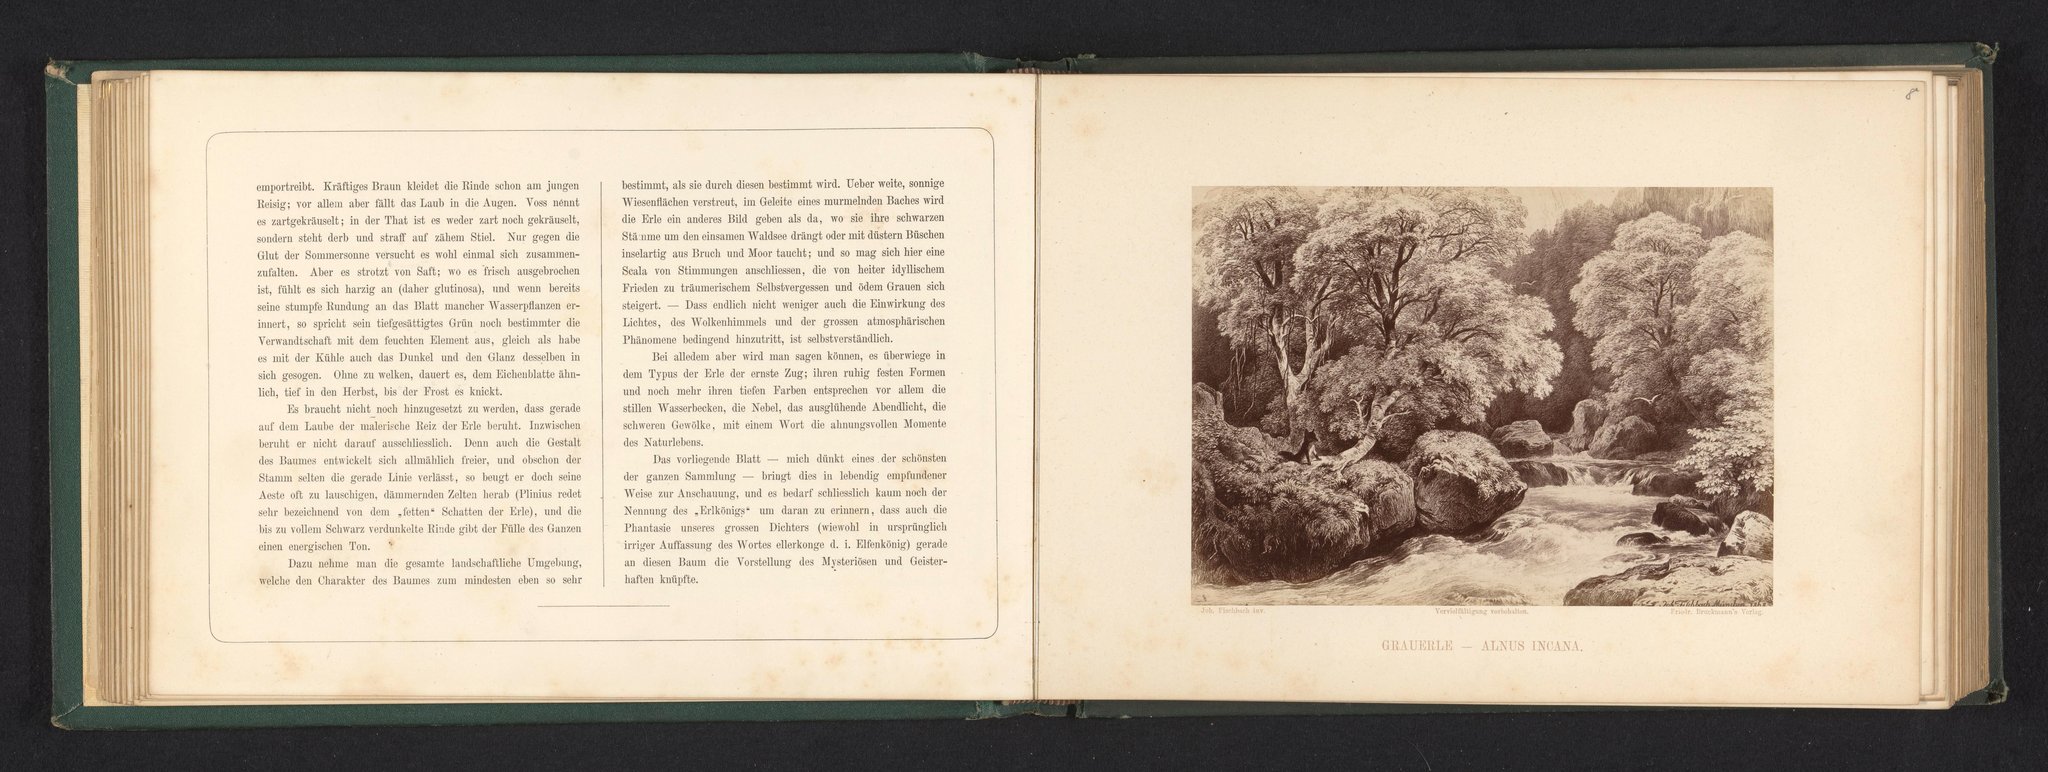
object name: photograph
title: Grauerle - Alnus Incana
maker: johann fischbach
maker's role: painter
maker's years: 1797-1871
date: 1868-1879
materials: photographic support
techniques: albumen print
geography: munich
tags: trees: alder